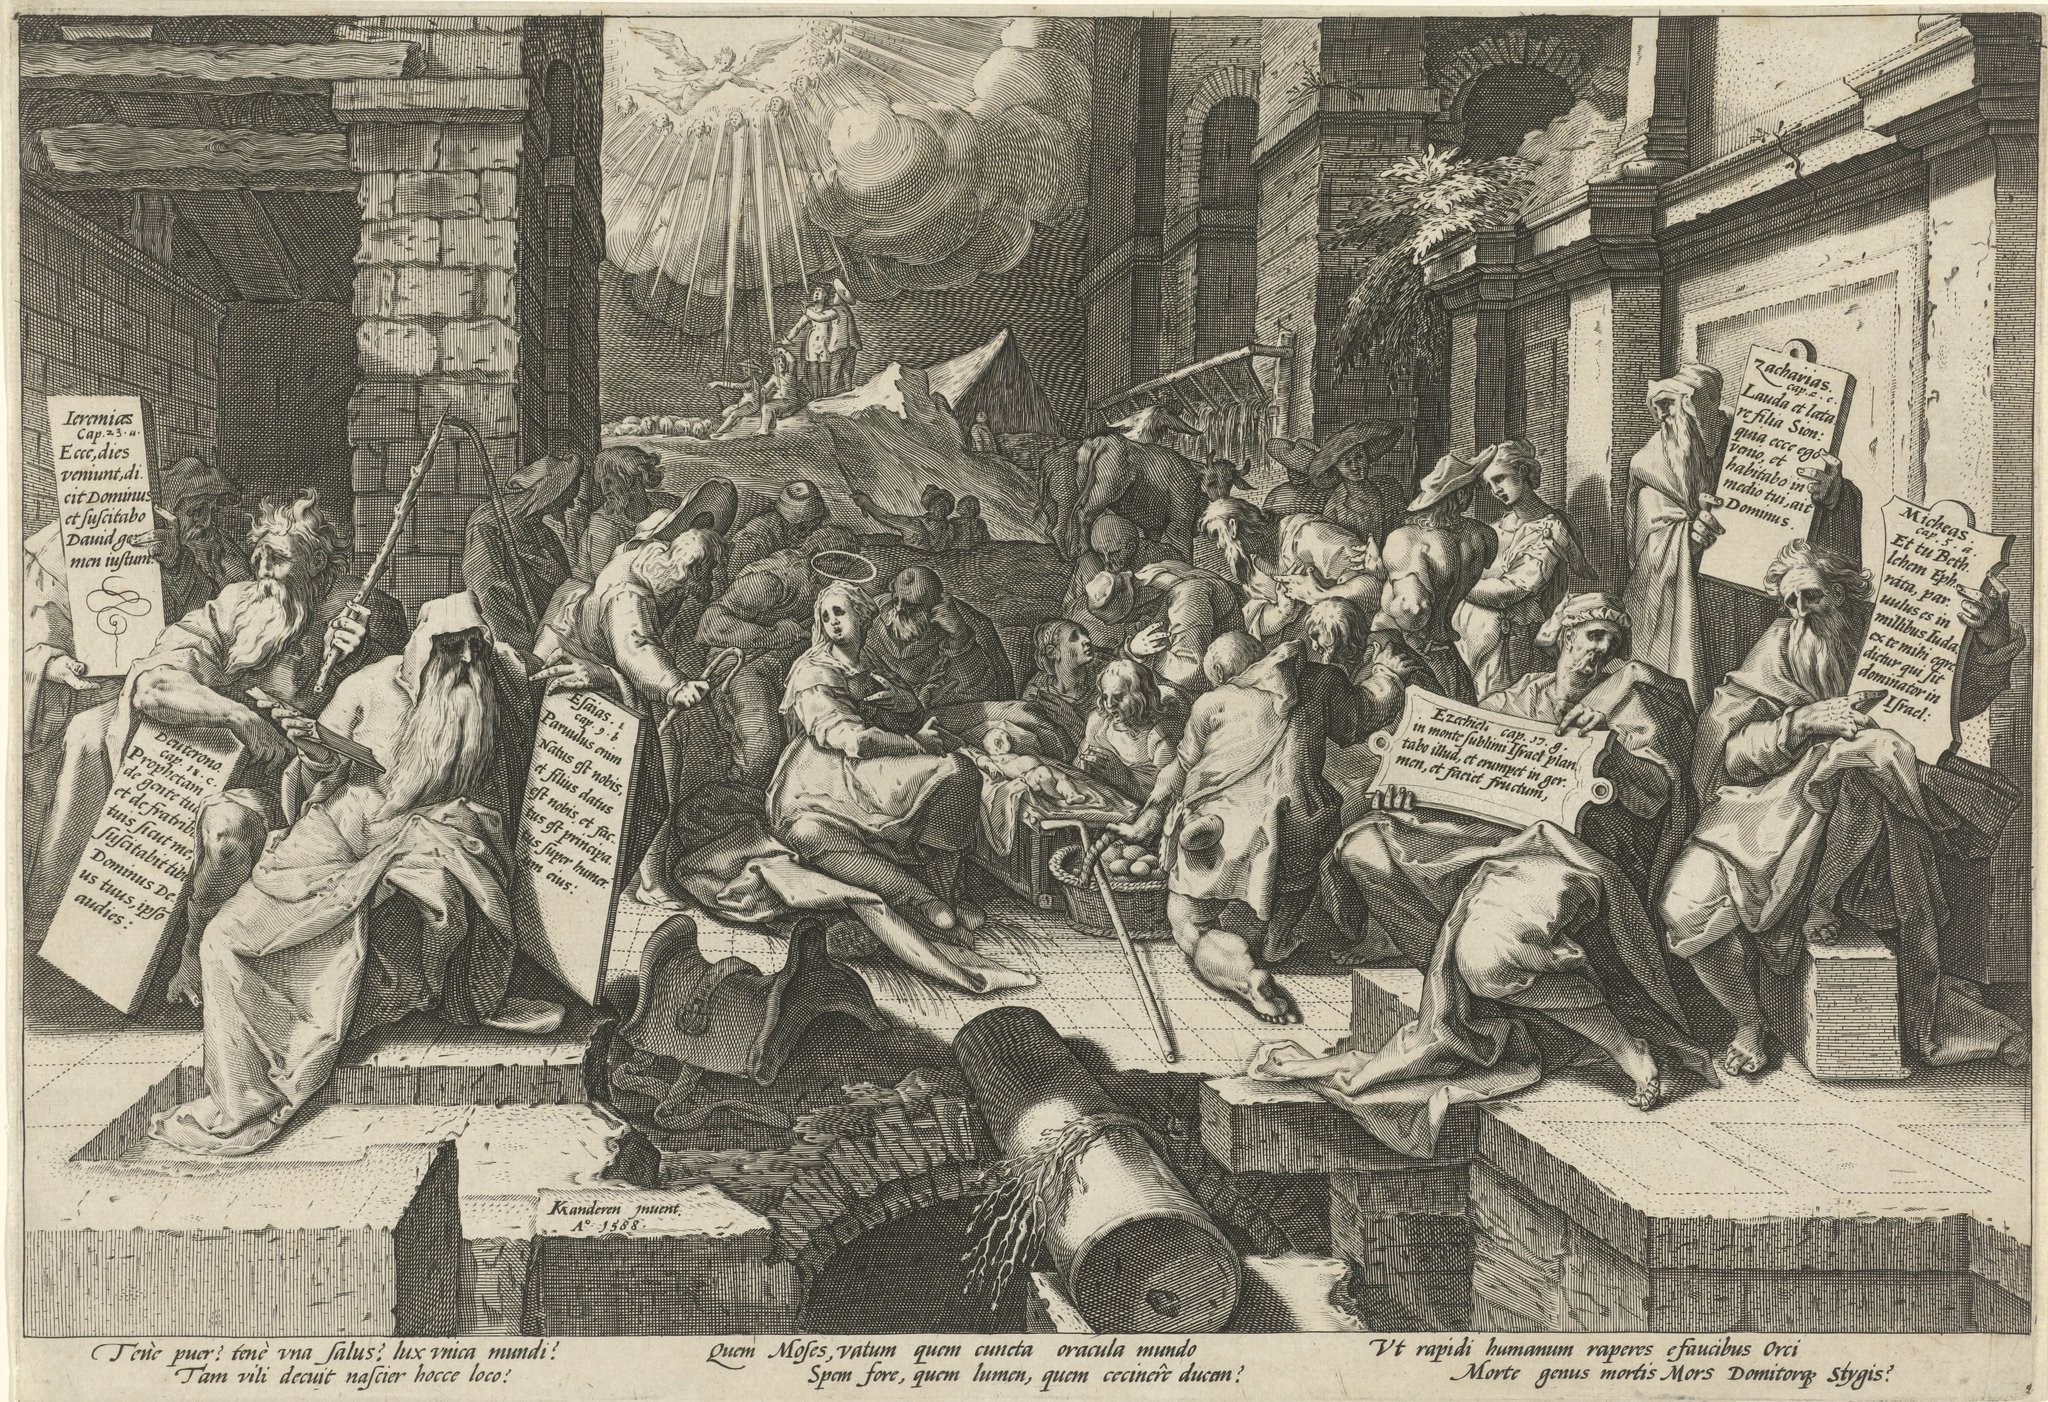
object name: print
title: Aanbidding der herders, op de voorgrond Mozes en vijf profeten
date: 1588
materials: paper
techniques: engraving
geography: haarlem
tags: adoration of the christ-child by the shepherds; mary and joseph present, male persons from the old testament (not in biblical context)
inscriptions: collector's mark: Lugt 240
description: Aanbidding der herders met de profeten Jeremia, Mozes en Jesaja links en Ezechiël Micha en Zacharias rechts. Mozes en de profeten uit het Oude Testament houden tabletten vast waarop zij de komst van Christus aankondigen.